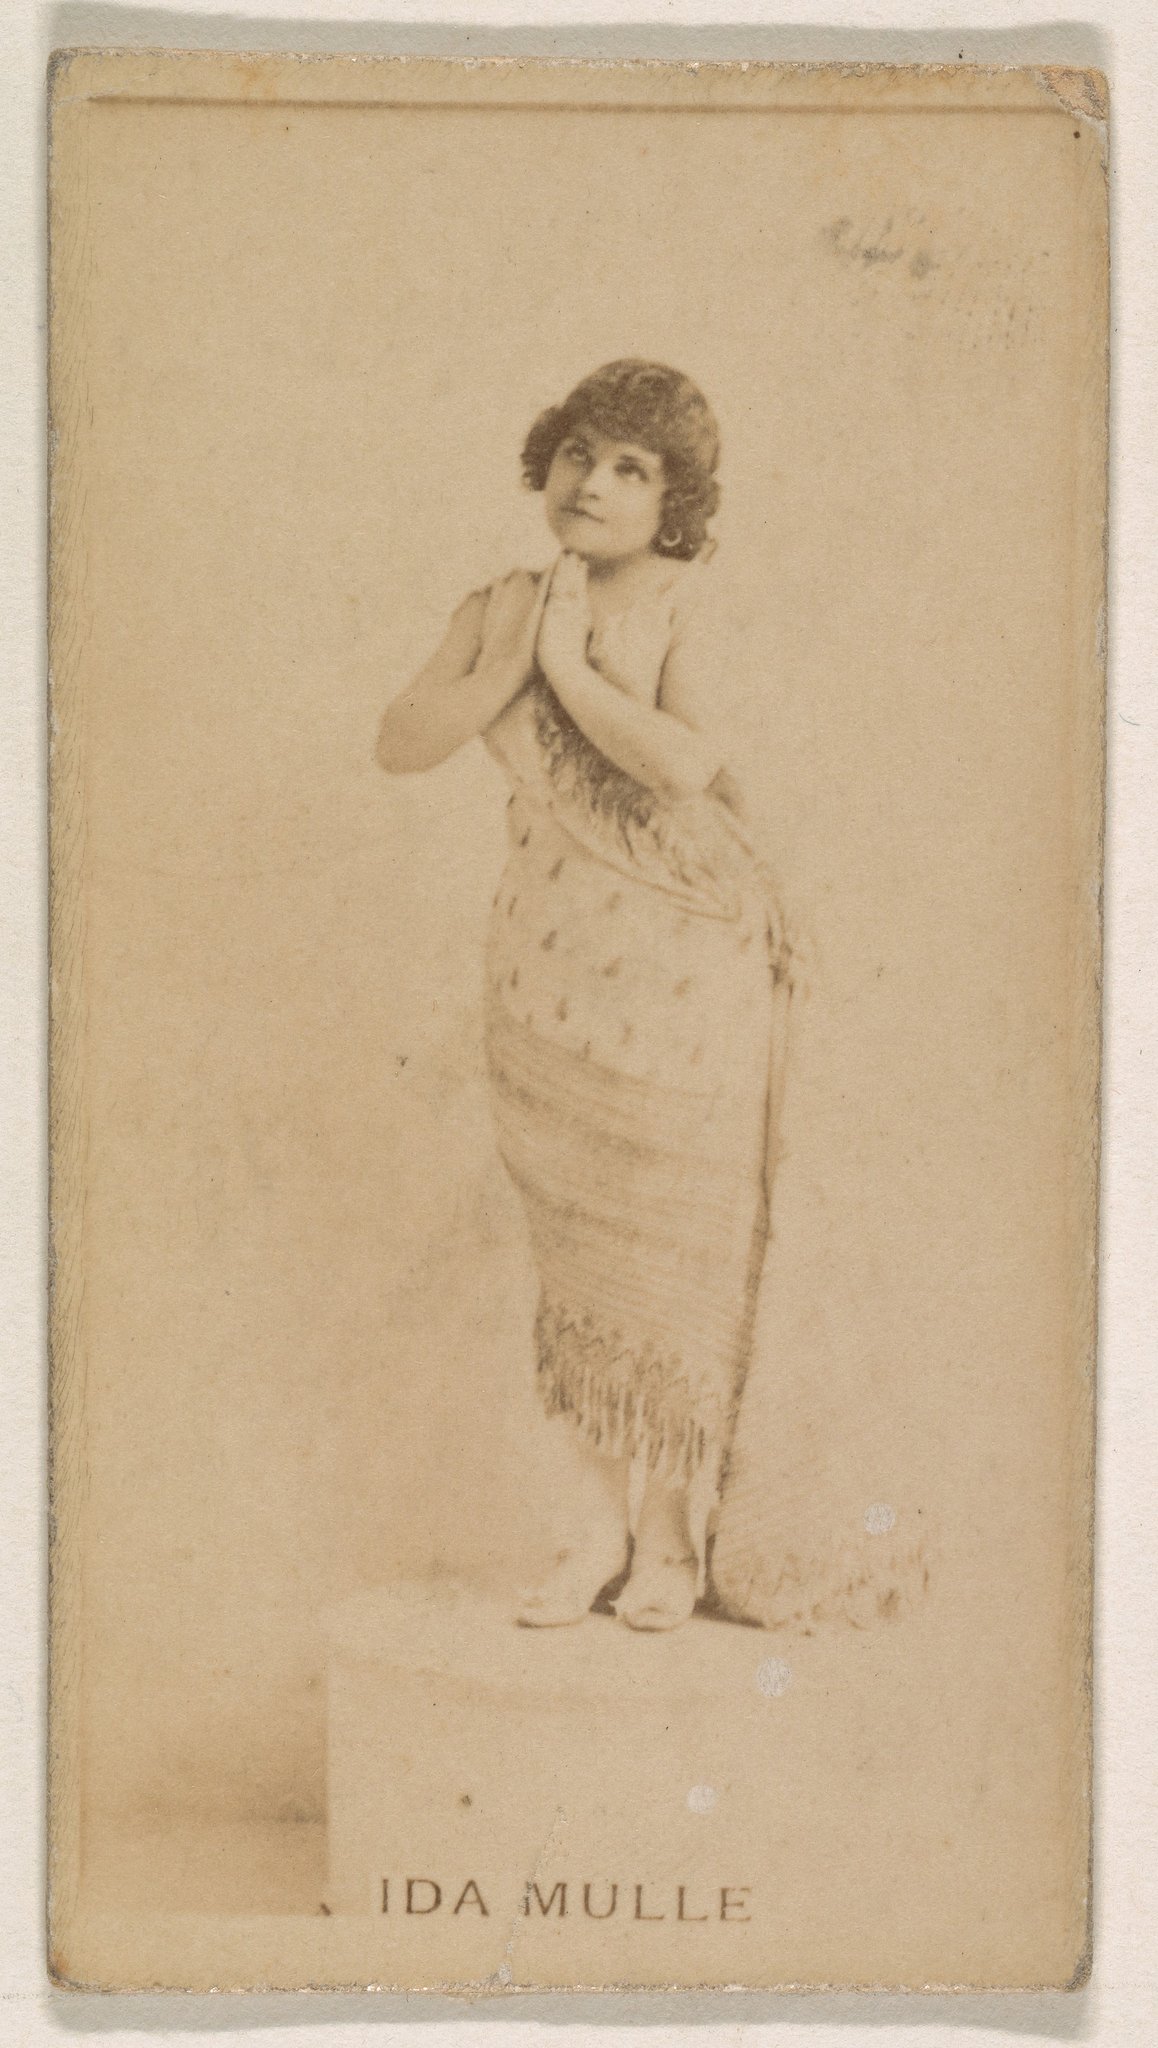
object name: photograph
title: Ida Mulle, from the Actresses series (N245) issued by Kinney Brothers to promote Sweet Caporal Cigarettes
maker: kinney brothers tobacco company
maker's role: publisher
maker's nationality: american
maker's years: 1869-2011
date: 1890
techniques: albumen silver print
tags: portraits,women,actresses